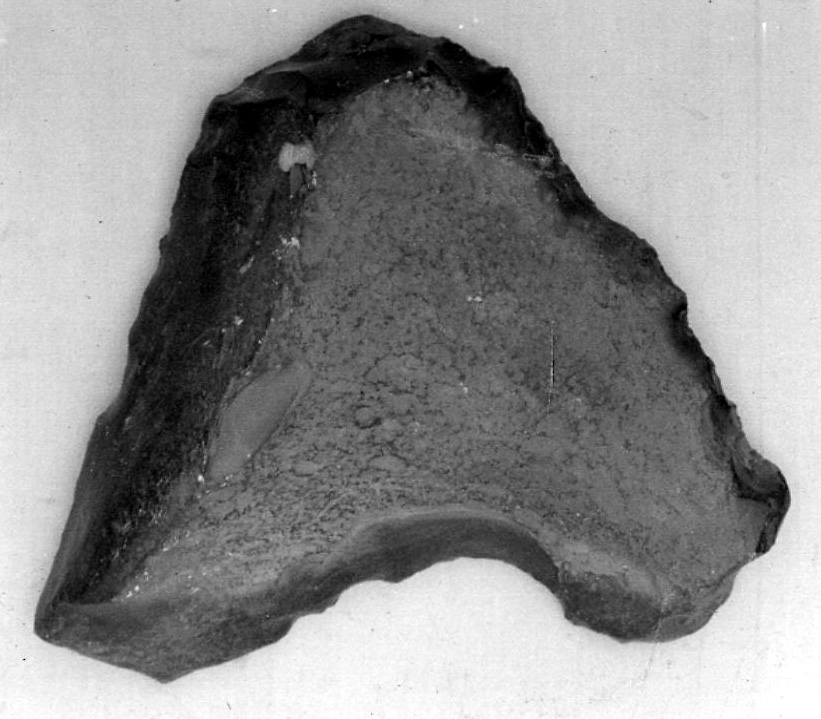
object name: tool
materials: stone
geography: egypt